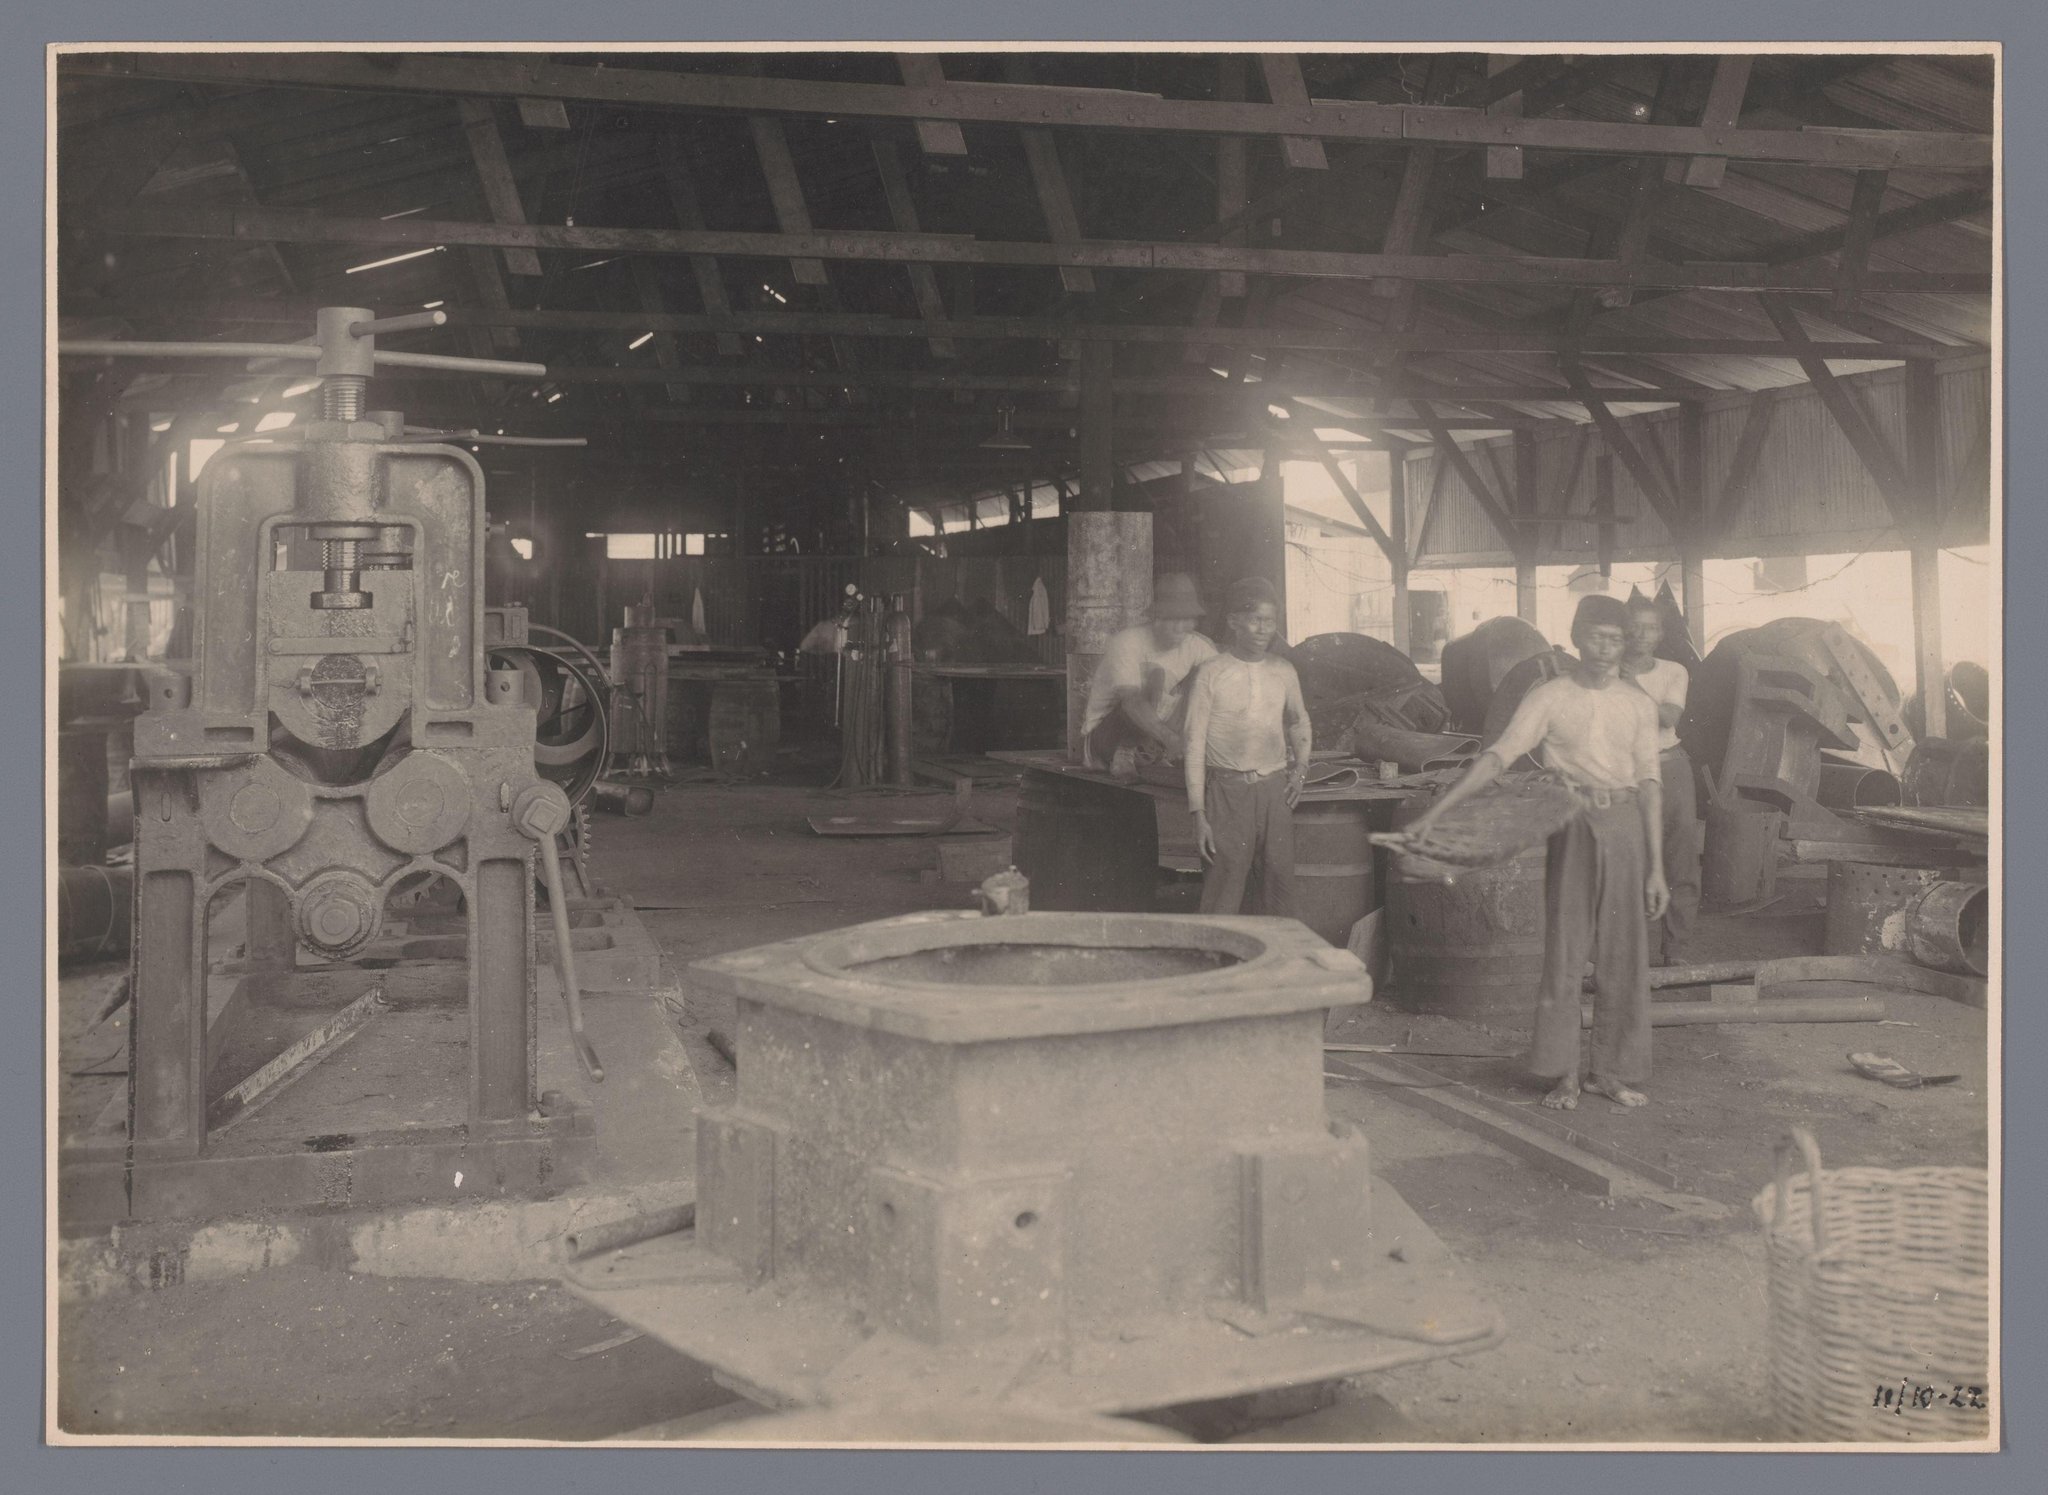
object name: photograph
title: Plaatwerkerij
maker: Anonymous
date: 1922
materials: photographic support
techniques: gelatin silver print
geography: belawan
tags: factory-interior, machine shop, machines; parts of machines; tools and appliances, building-site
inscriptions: date: ‘10/10-22’, annotation: ‘No. 251 Plaatwerkerij’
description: Gezicht in de machinewerkplaats, met enkele arbeiders. Genummerd: 251. Onderdeel van de groep van losse foto's over de aanleg van de haven Belawan aan de kust voor Medan, Sumatra 1921-1922.